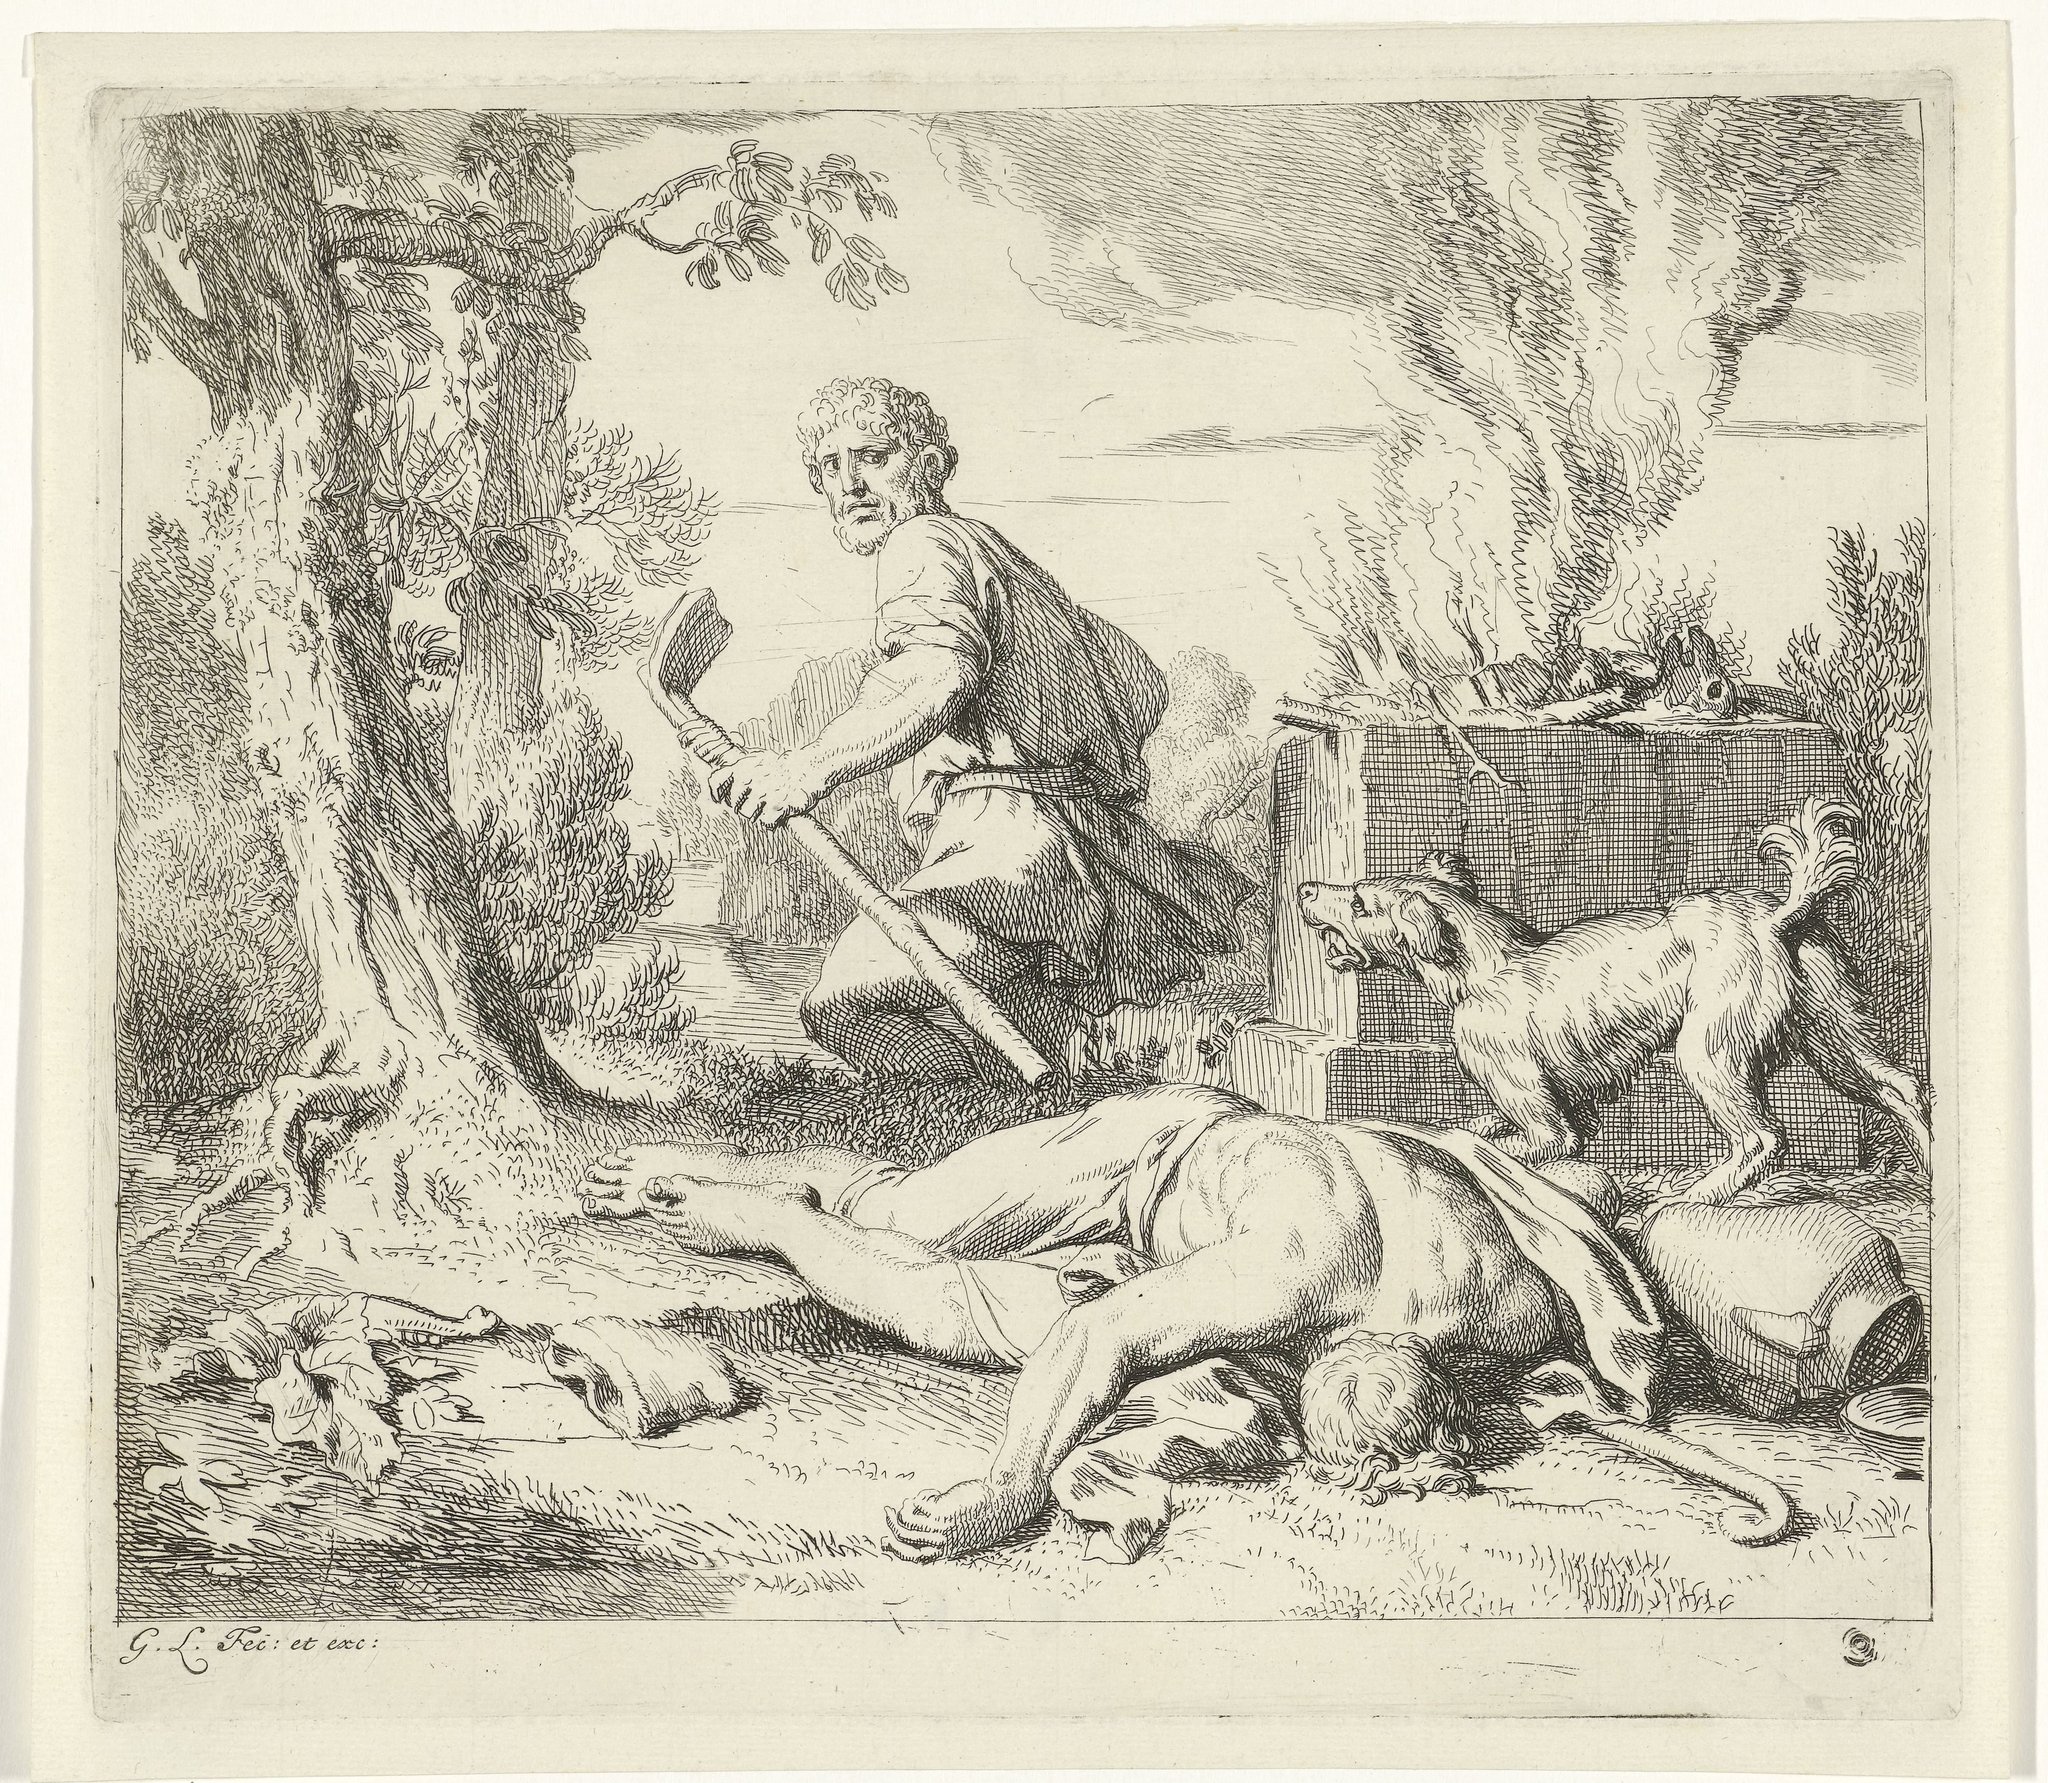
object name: print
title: Kaïn vlucht na de moord op Abel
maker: gerard de lairesse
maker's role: draughtsman, painter, print maker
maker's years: 1641-1711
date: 1665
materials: paper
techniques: etching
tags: the flight of cain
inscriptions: collector's mark: Lugt 240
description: Kaïn slaat op de vlucht nadat hij Abel heeft doodgeslagen. Hij kijkt om naar een blaffende hond. Op de voorgrond ligt het dode lichaam van Abel. De prent maakt deel uit van een zevendelige serie met scènes uit het Bijbelboek Genesis.